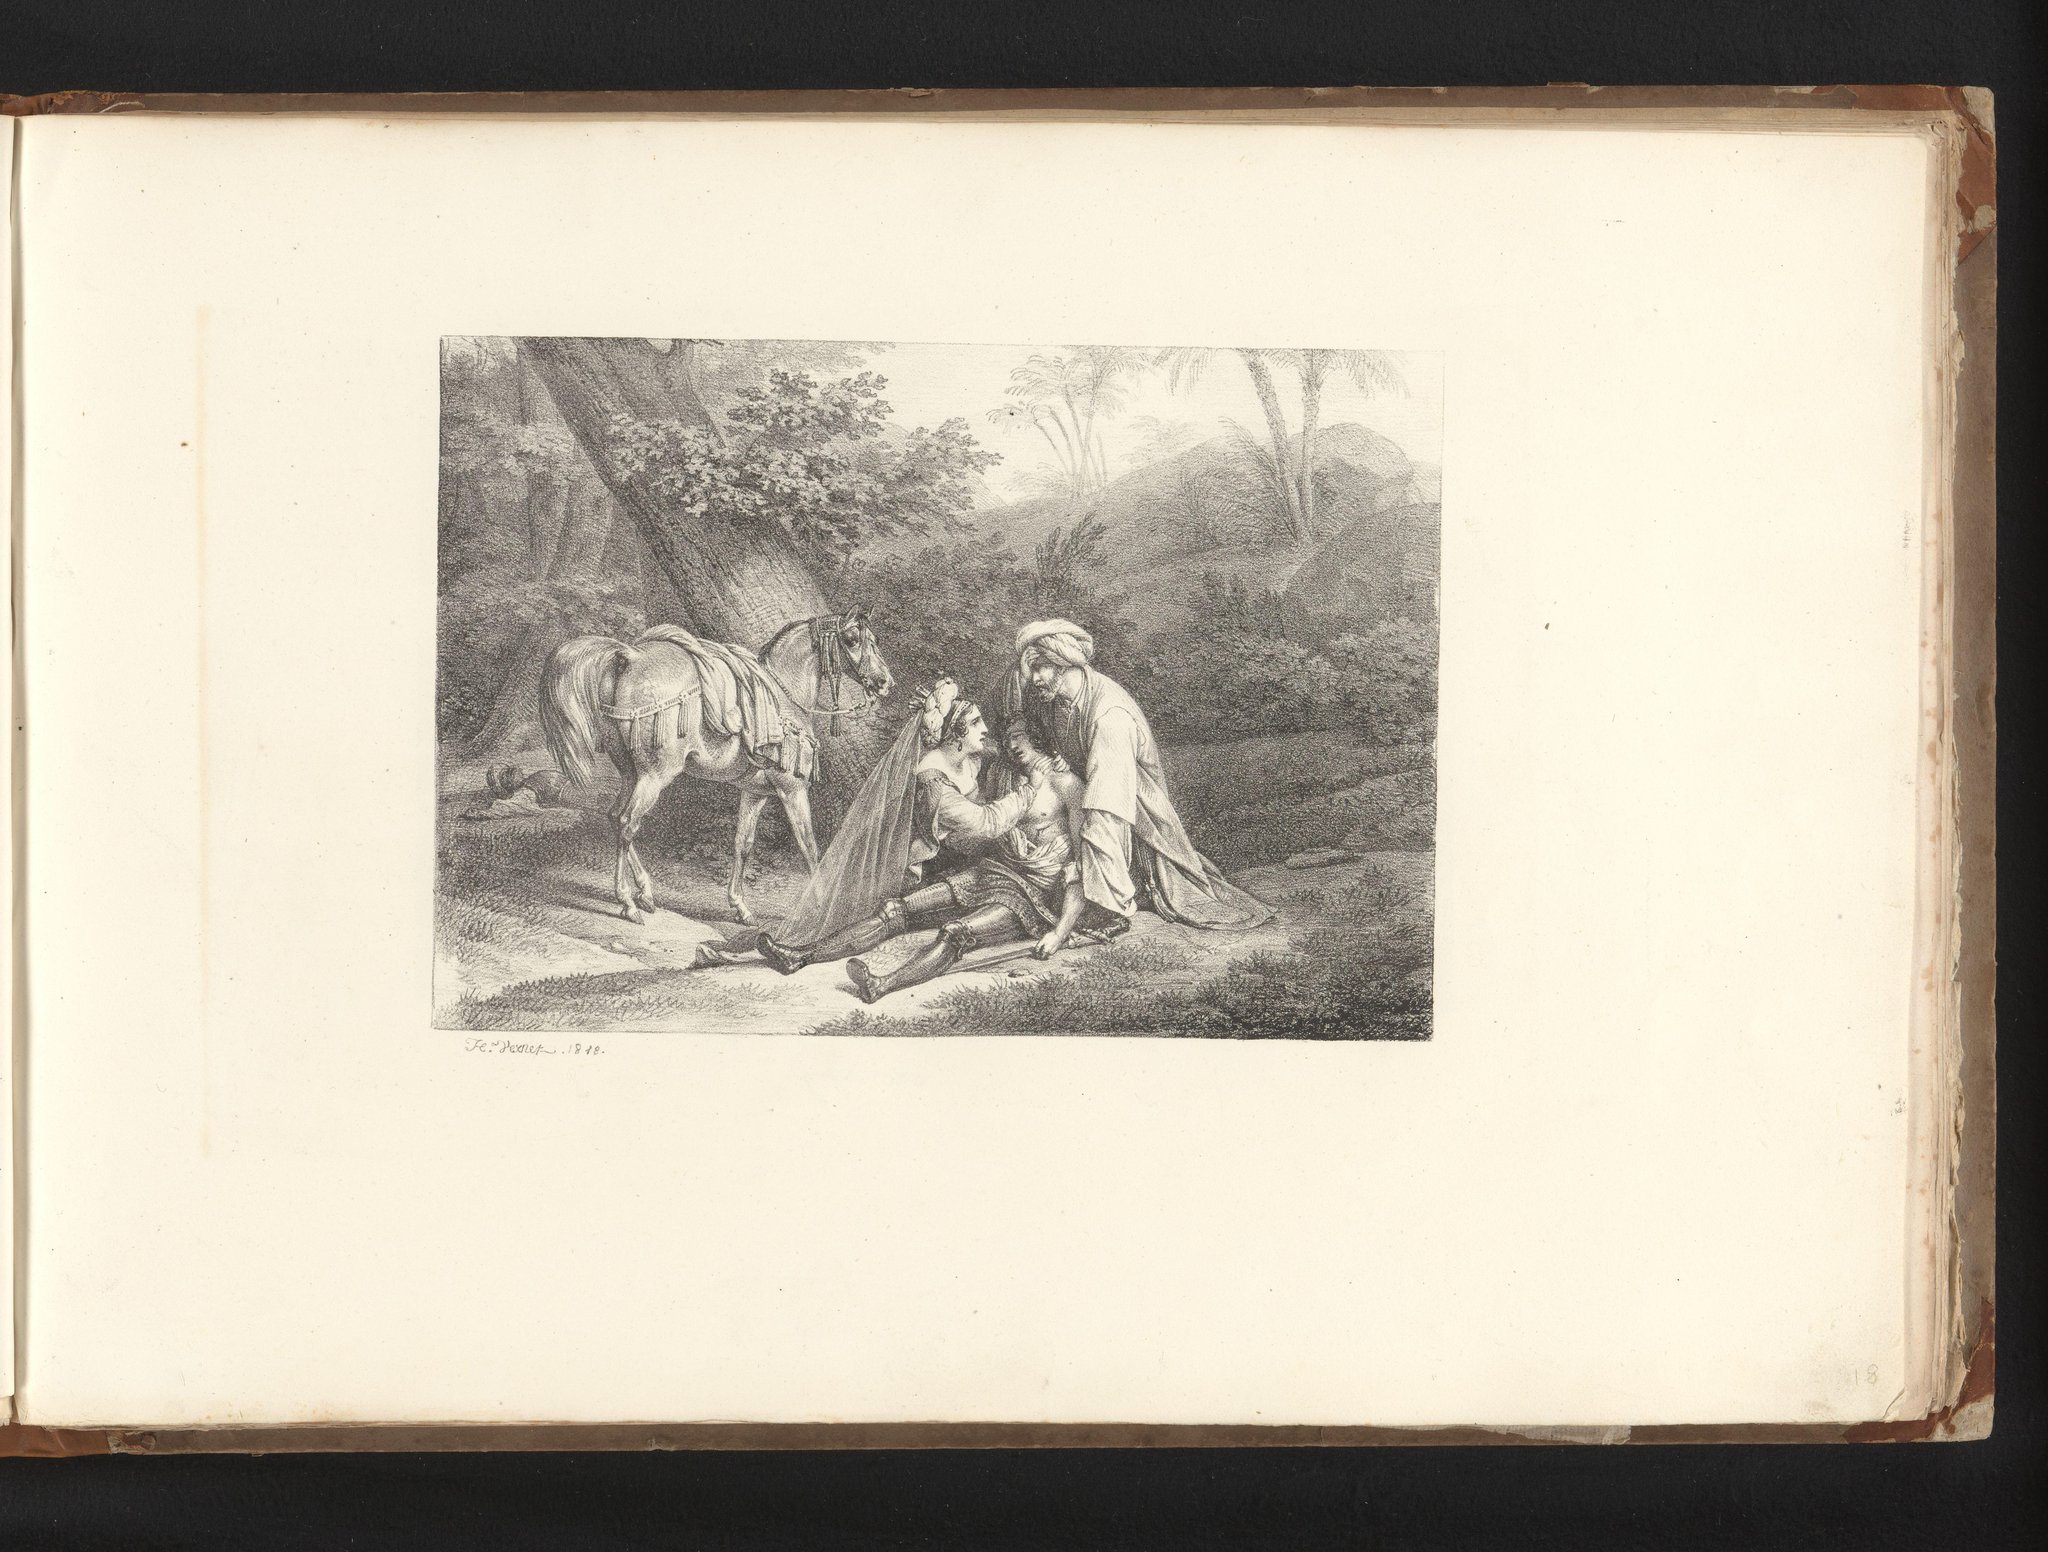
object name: album leaf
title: Serie lithografieën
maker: horace vernet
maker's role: draughtsman, painter, print maker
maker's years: 1789-1863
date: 1818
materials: paper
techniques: lithograph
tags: battle, dying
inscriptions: date